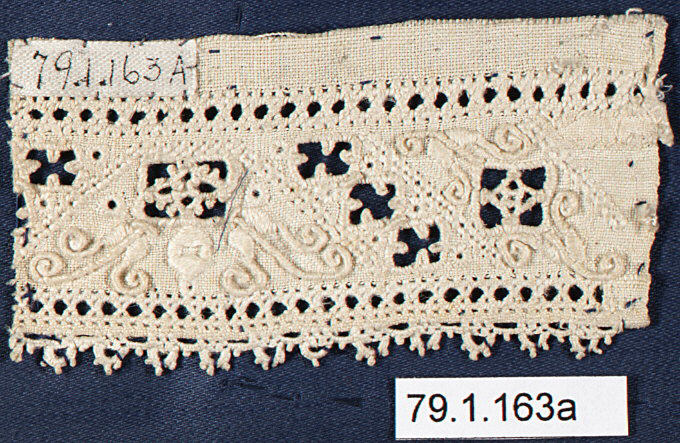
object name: fragment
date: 1501-1600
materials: linen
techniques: embroidery